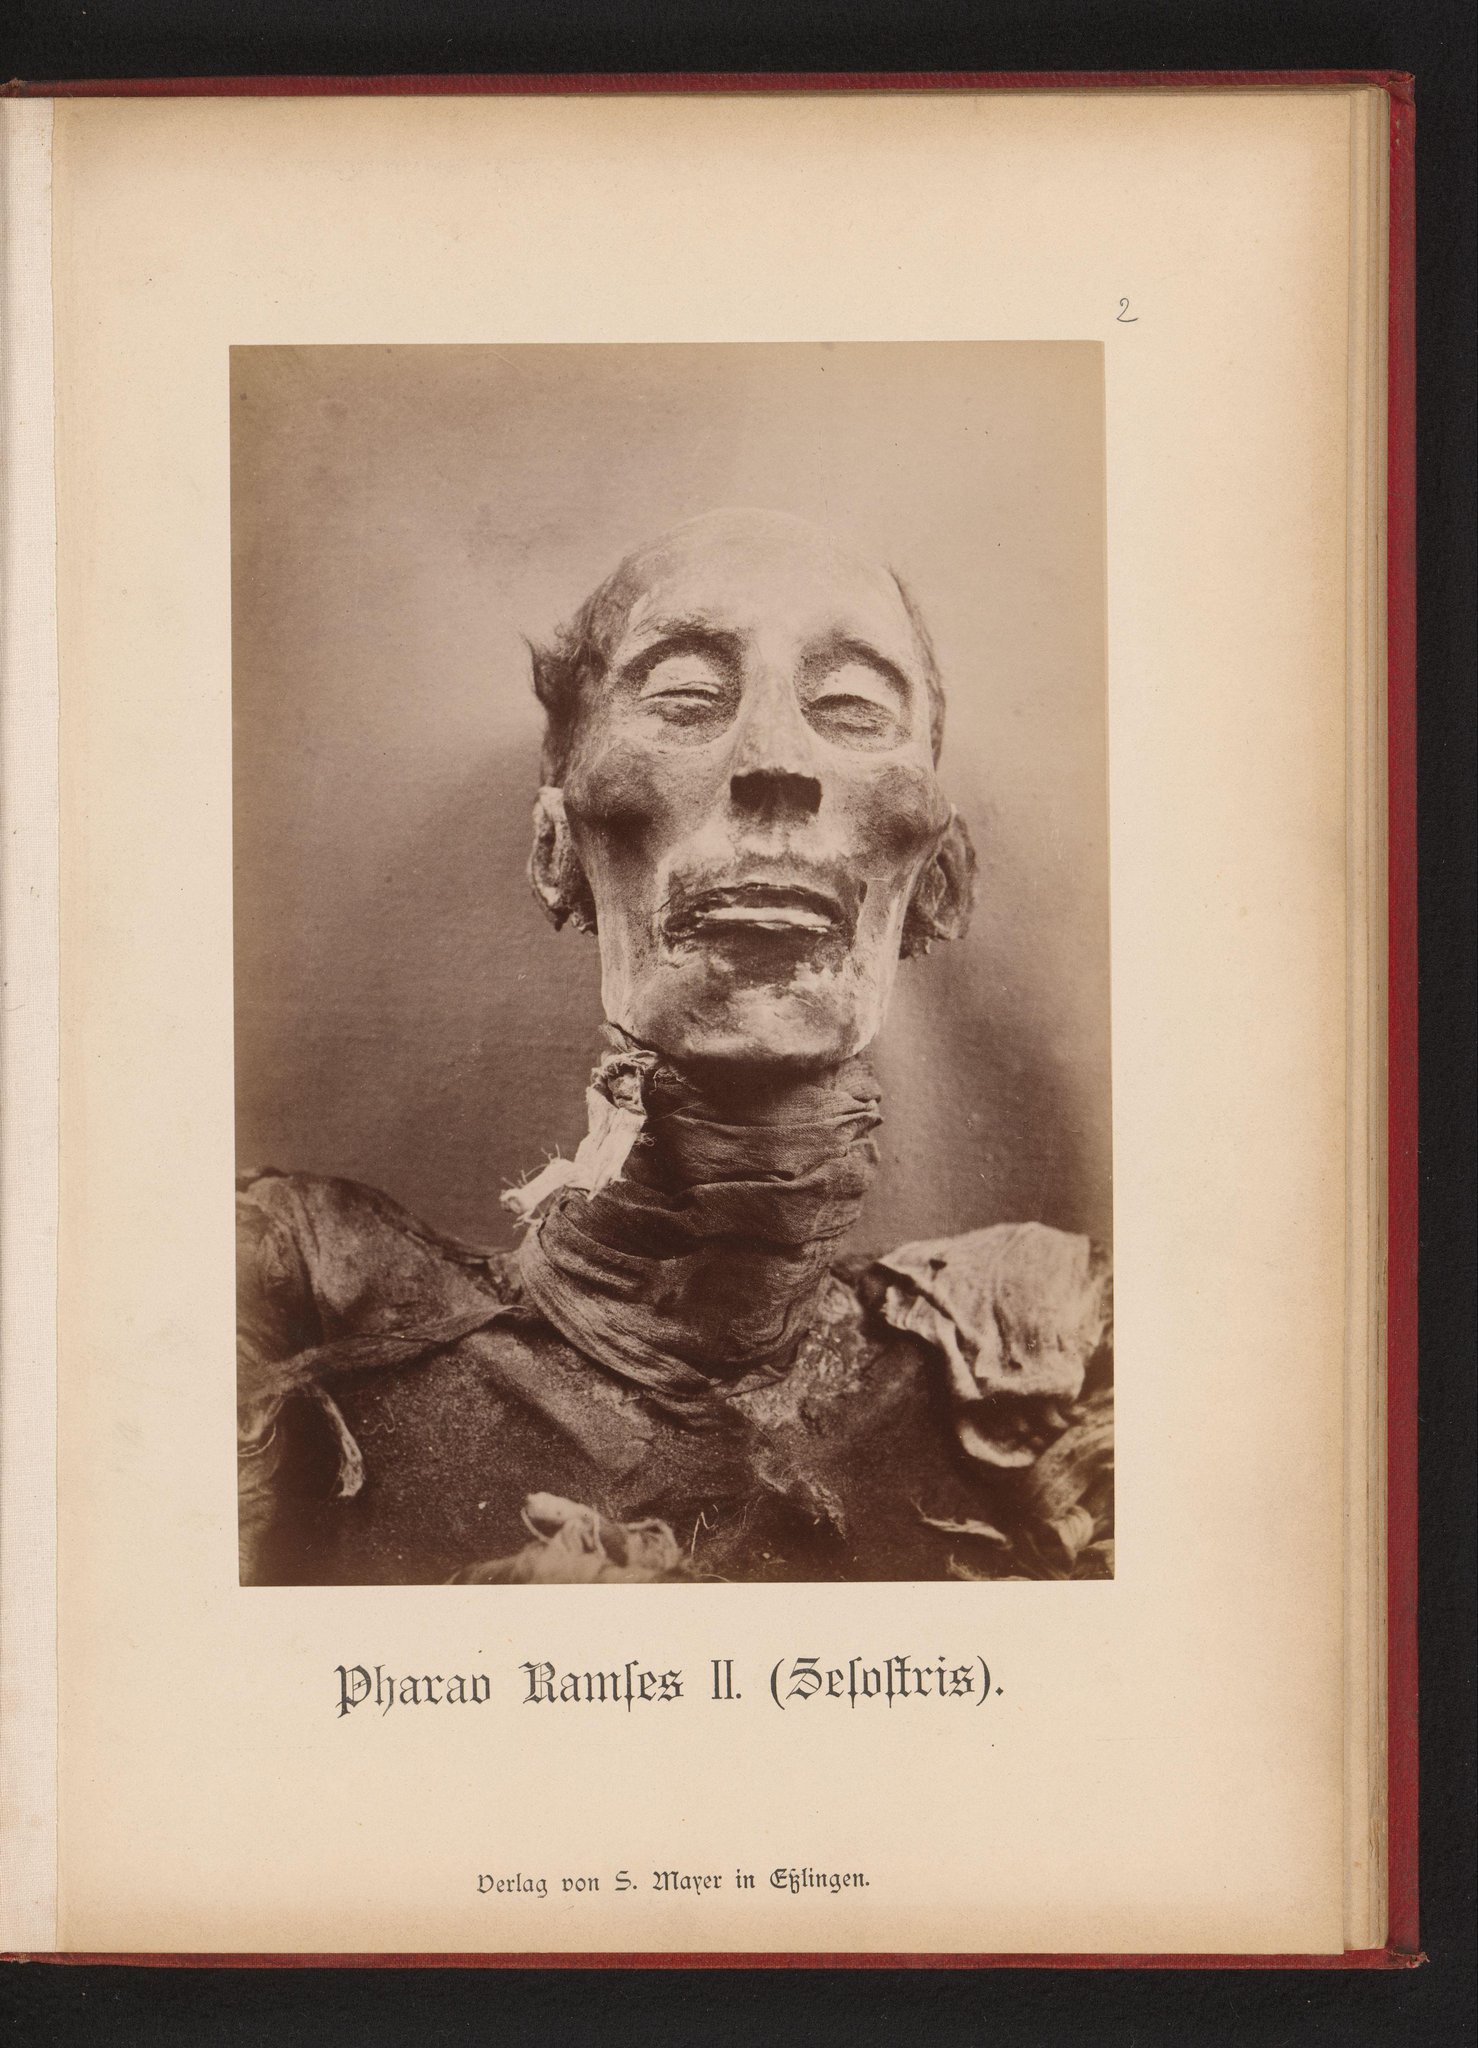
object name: photograph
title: Hoofd van de mummie van farao Ramses II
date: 1881-1886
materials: photographic support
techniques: albumen print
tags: king, mummy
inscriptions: inscription: ‘Verlag von S. Mayer in Esslingen’